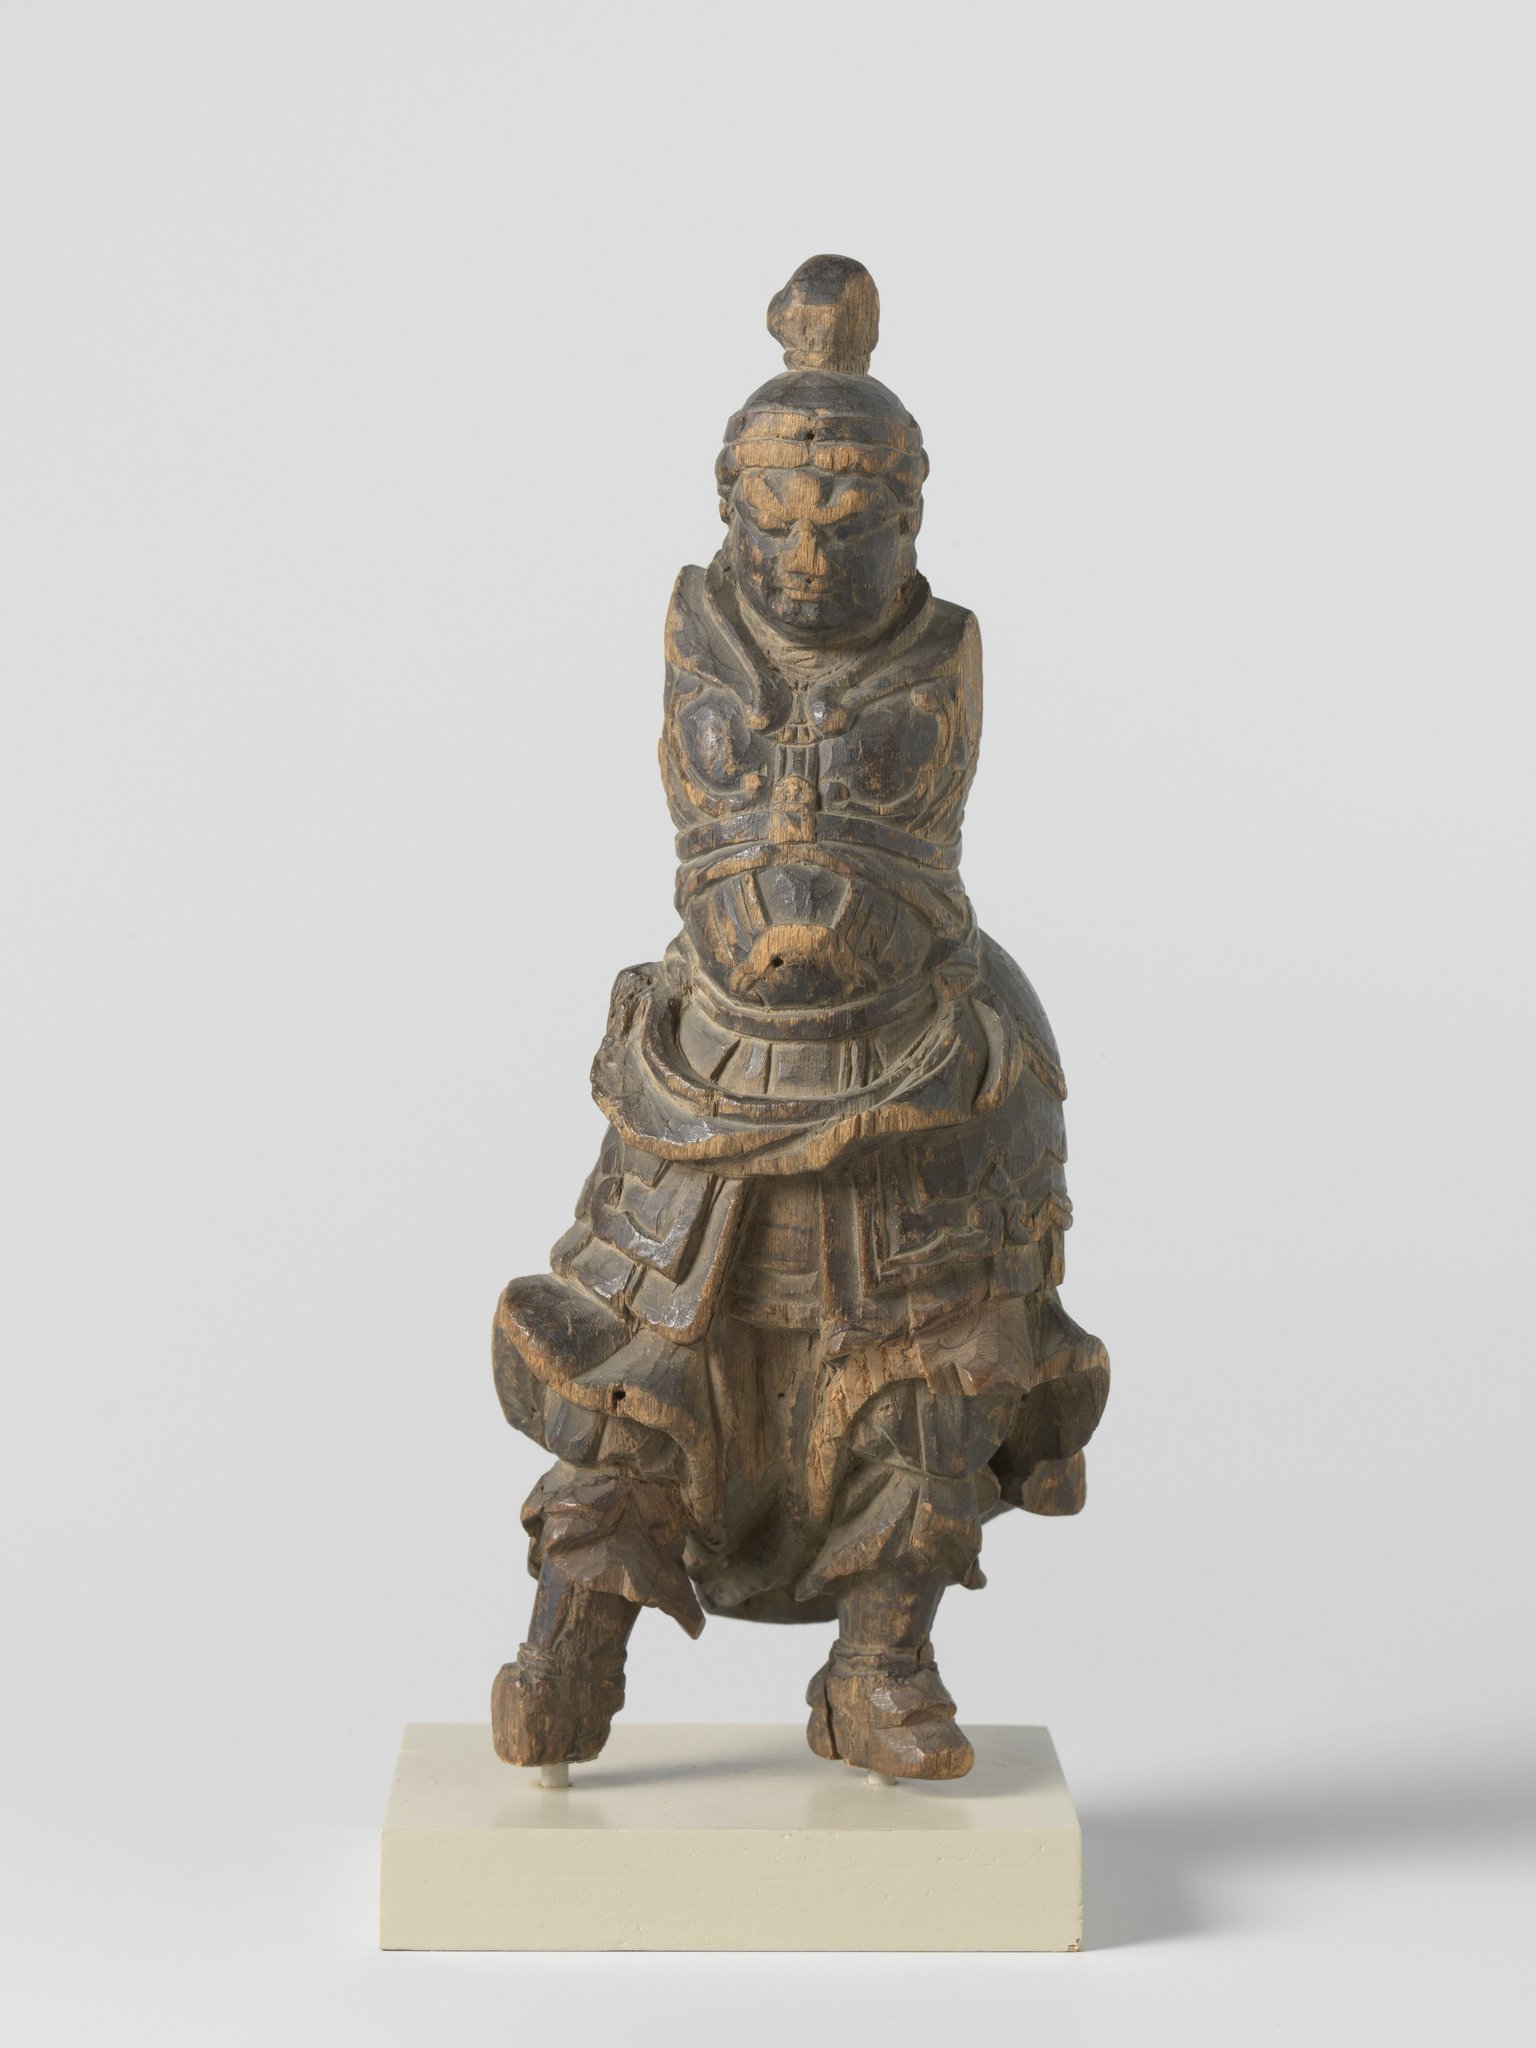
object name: figure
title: Beeldhouwwerk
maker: Anonymous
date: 1400-1500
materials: wood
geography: japan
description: Staande Bishamonten; de armen ontbreken en de linkervoet is gedeeltelijk afgebroken.